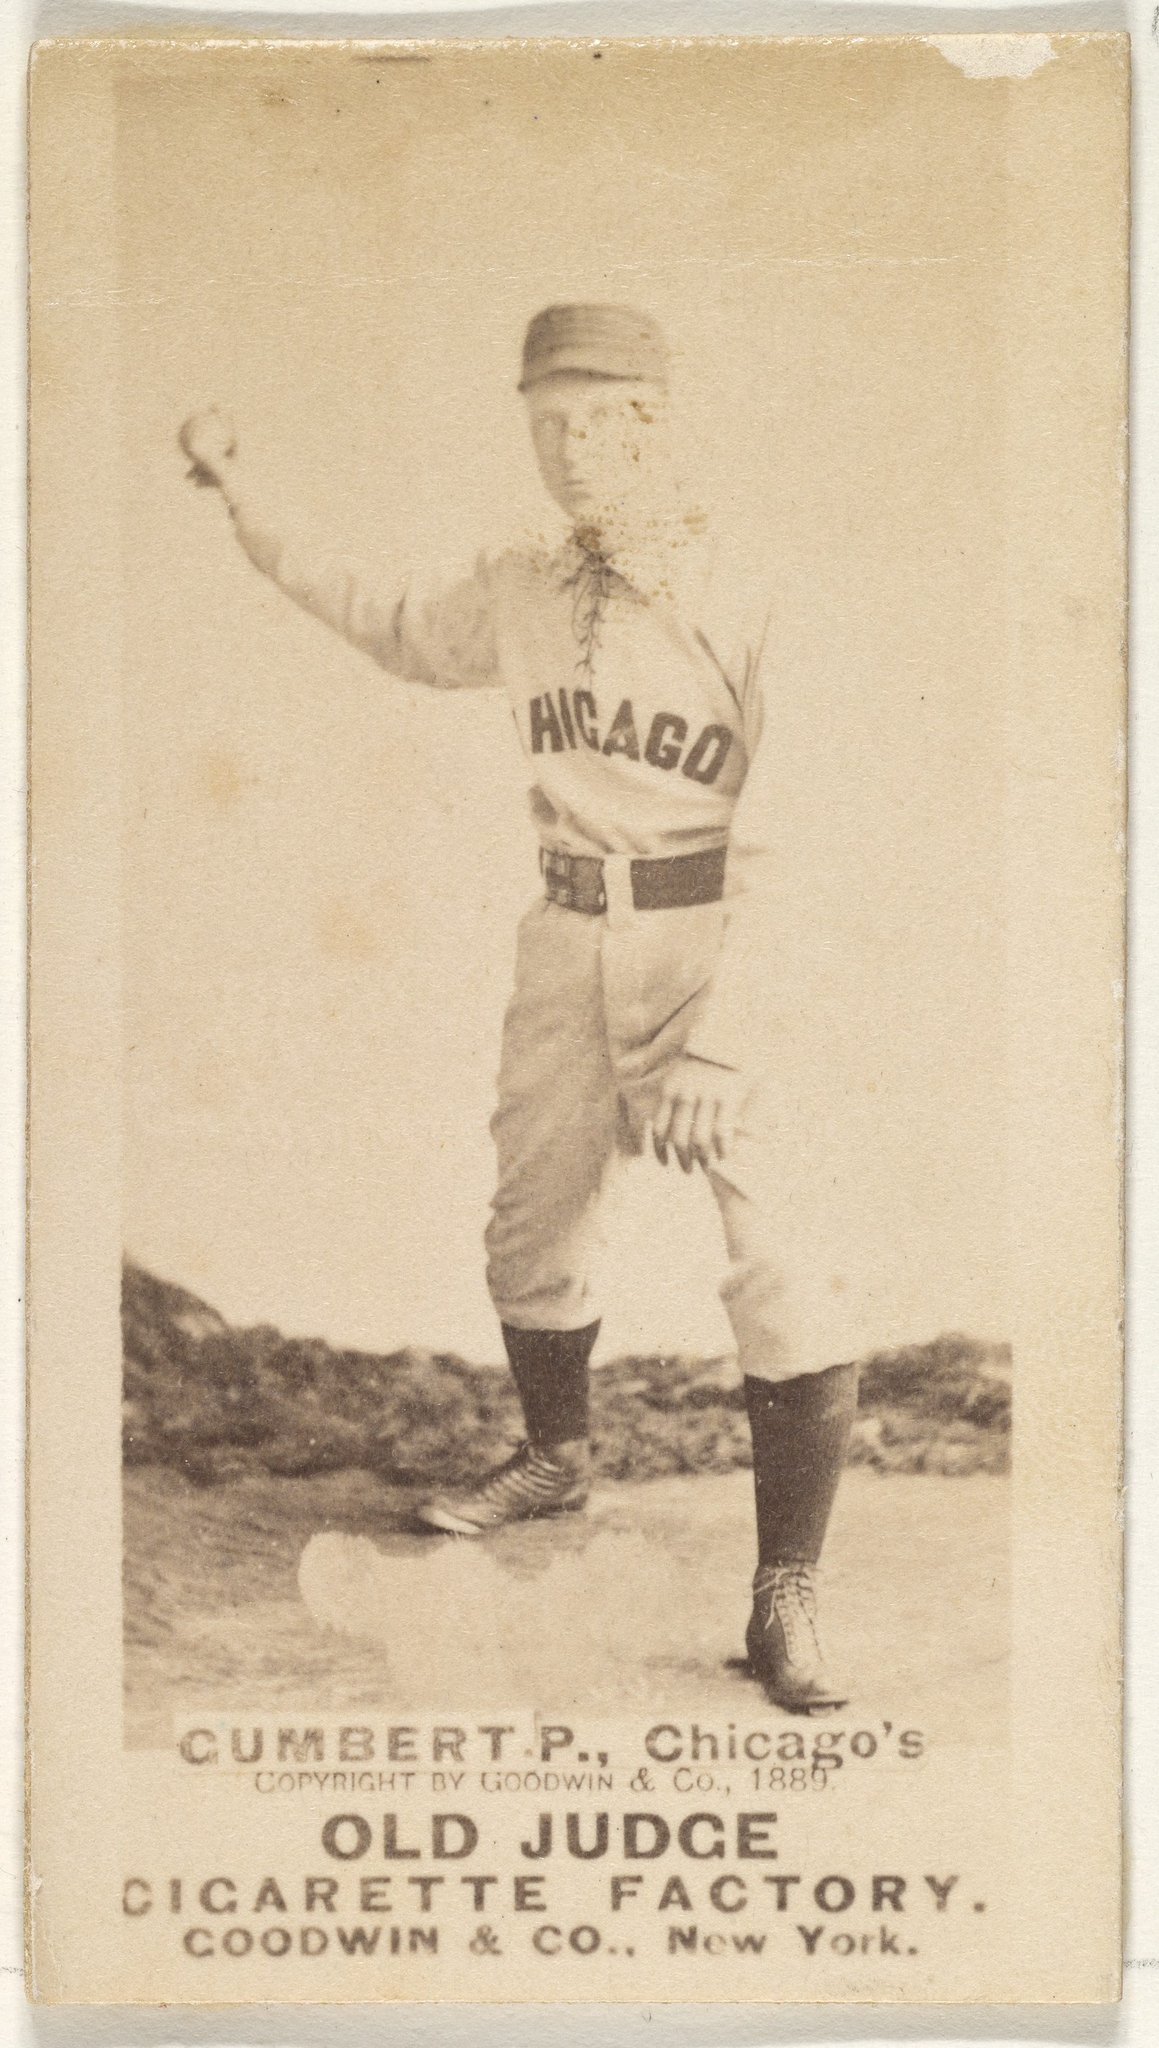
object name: baseball card, photograph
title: Gumbert, Pitcher, Chicago, from the Old Judge series (N172) for Old Judge Cigarettes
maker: goodwin & company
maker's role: publisher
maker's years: 1850-1950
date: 1889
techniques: albumen silver print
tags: men,portraits,baseball,athletes